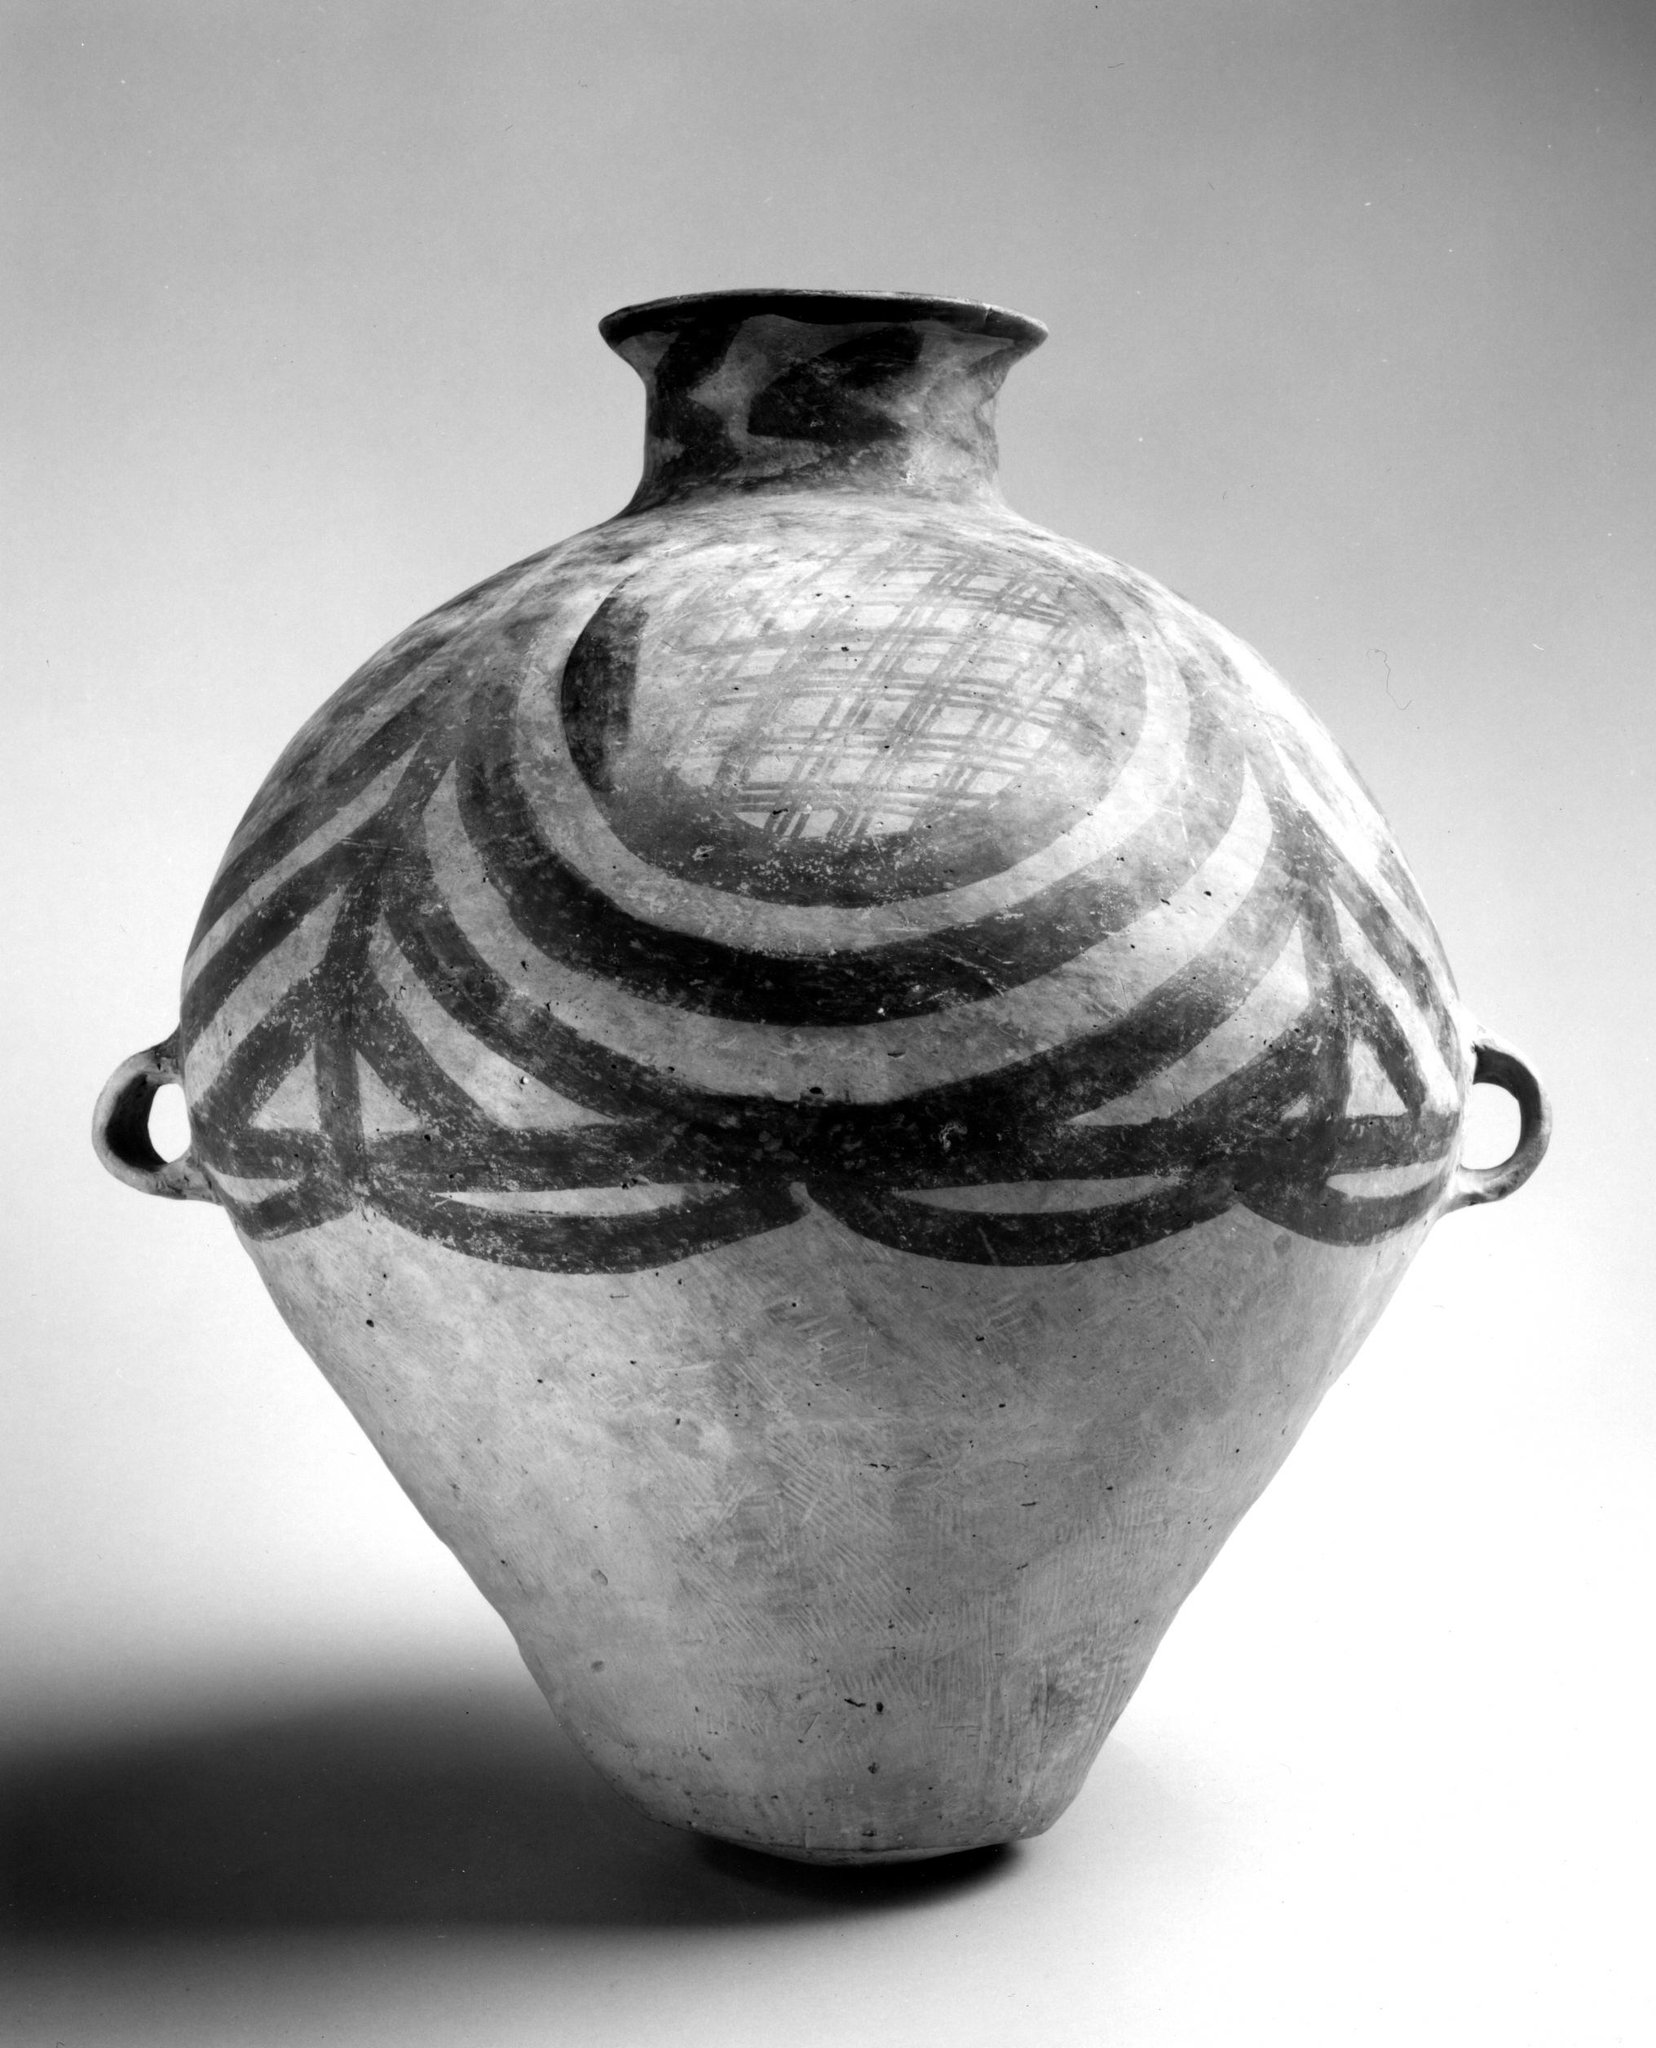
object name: jar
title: Ovoid Jar (Hu)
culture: chinese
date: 2300-2000 BCE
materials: earthenware, pigment